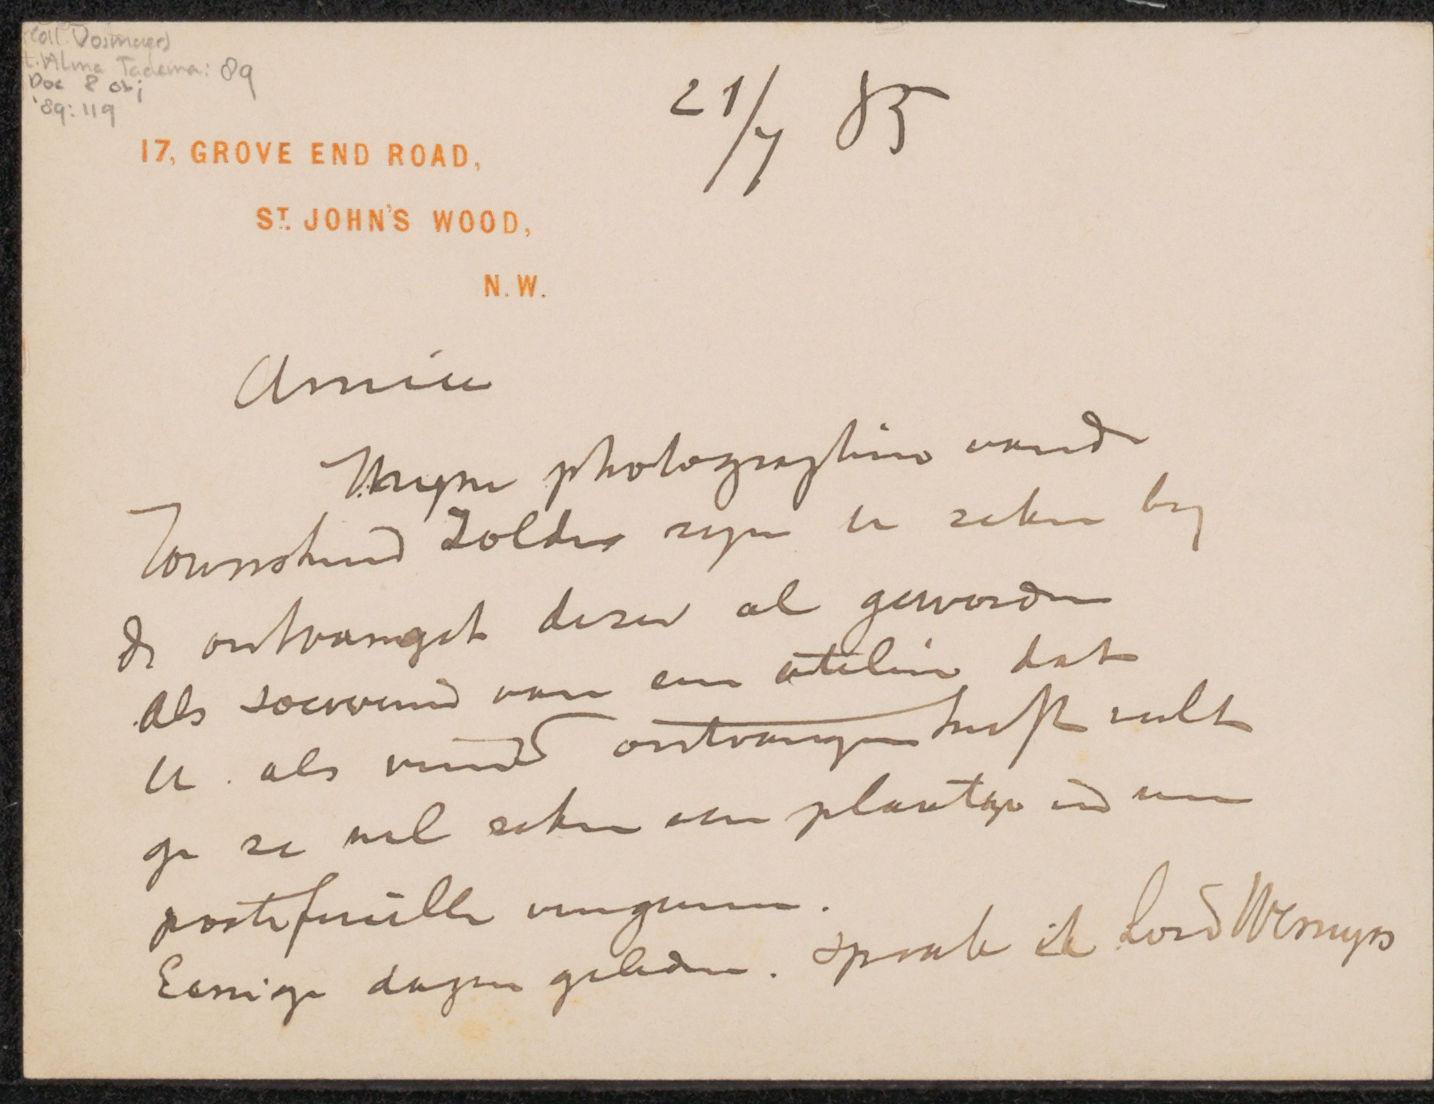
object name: letter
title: Brief aan Carel Vosmaer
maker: lourens alma tadema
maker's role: draughtsman, print maker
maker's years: 1836-1912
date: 1885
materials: cardboard, ink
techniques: pen, printing, writing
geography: london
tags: the hague, carel vosmaer